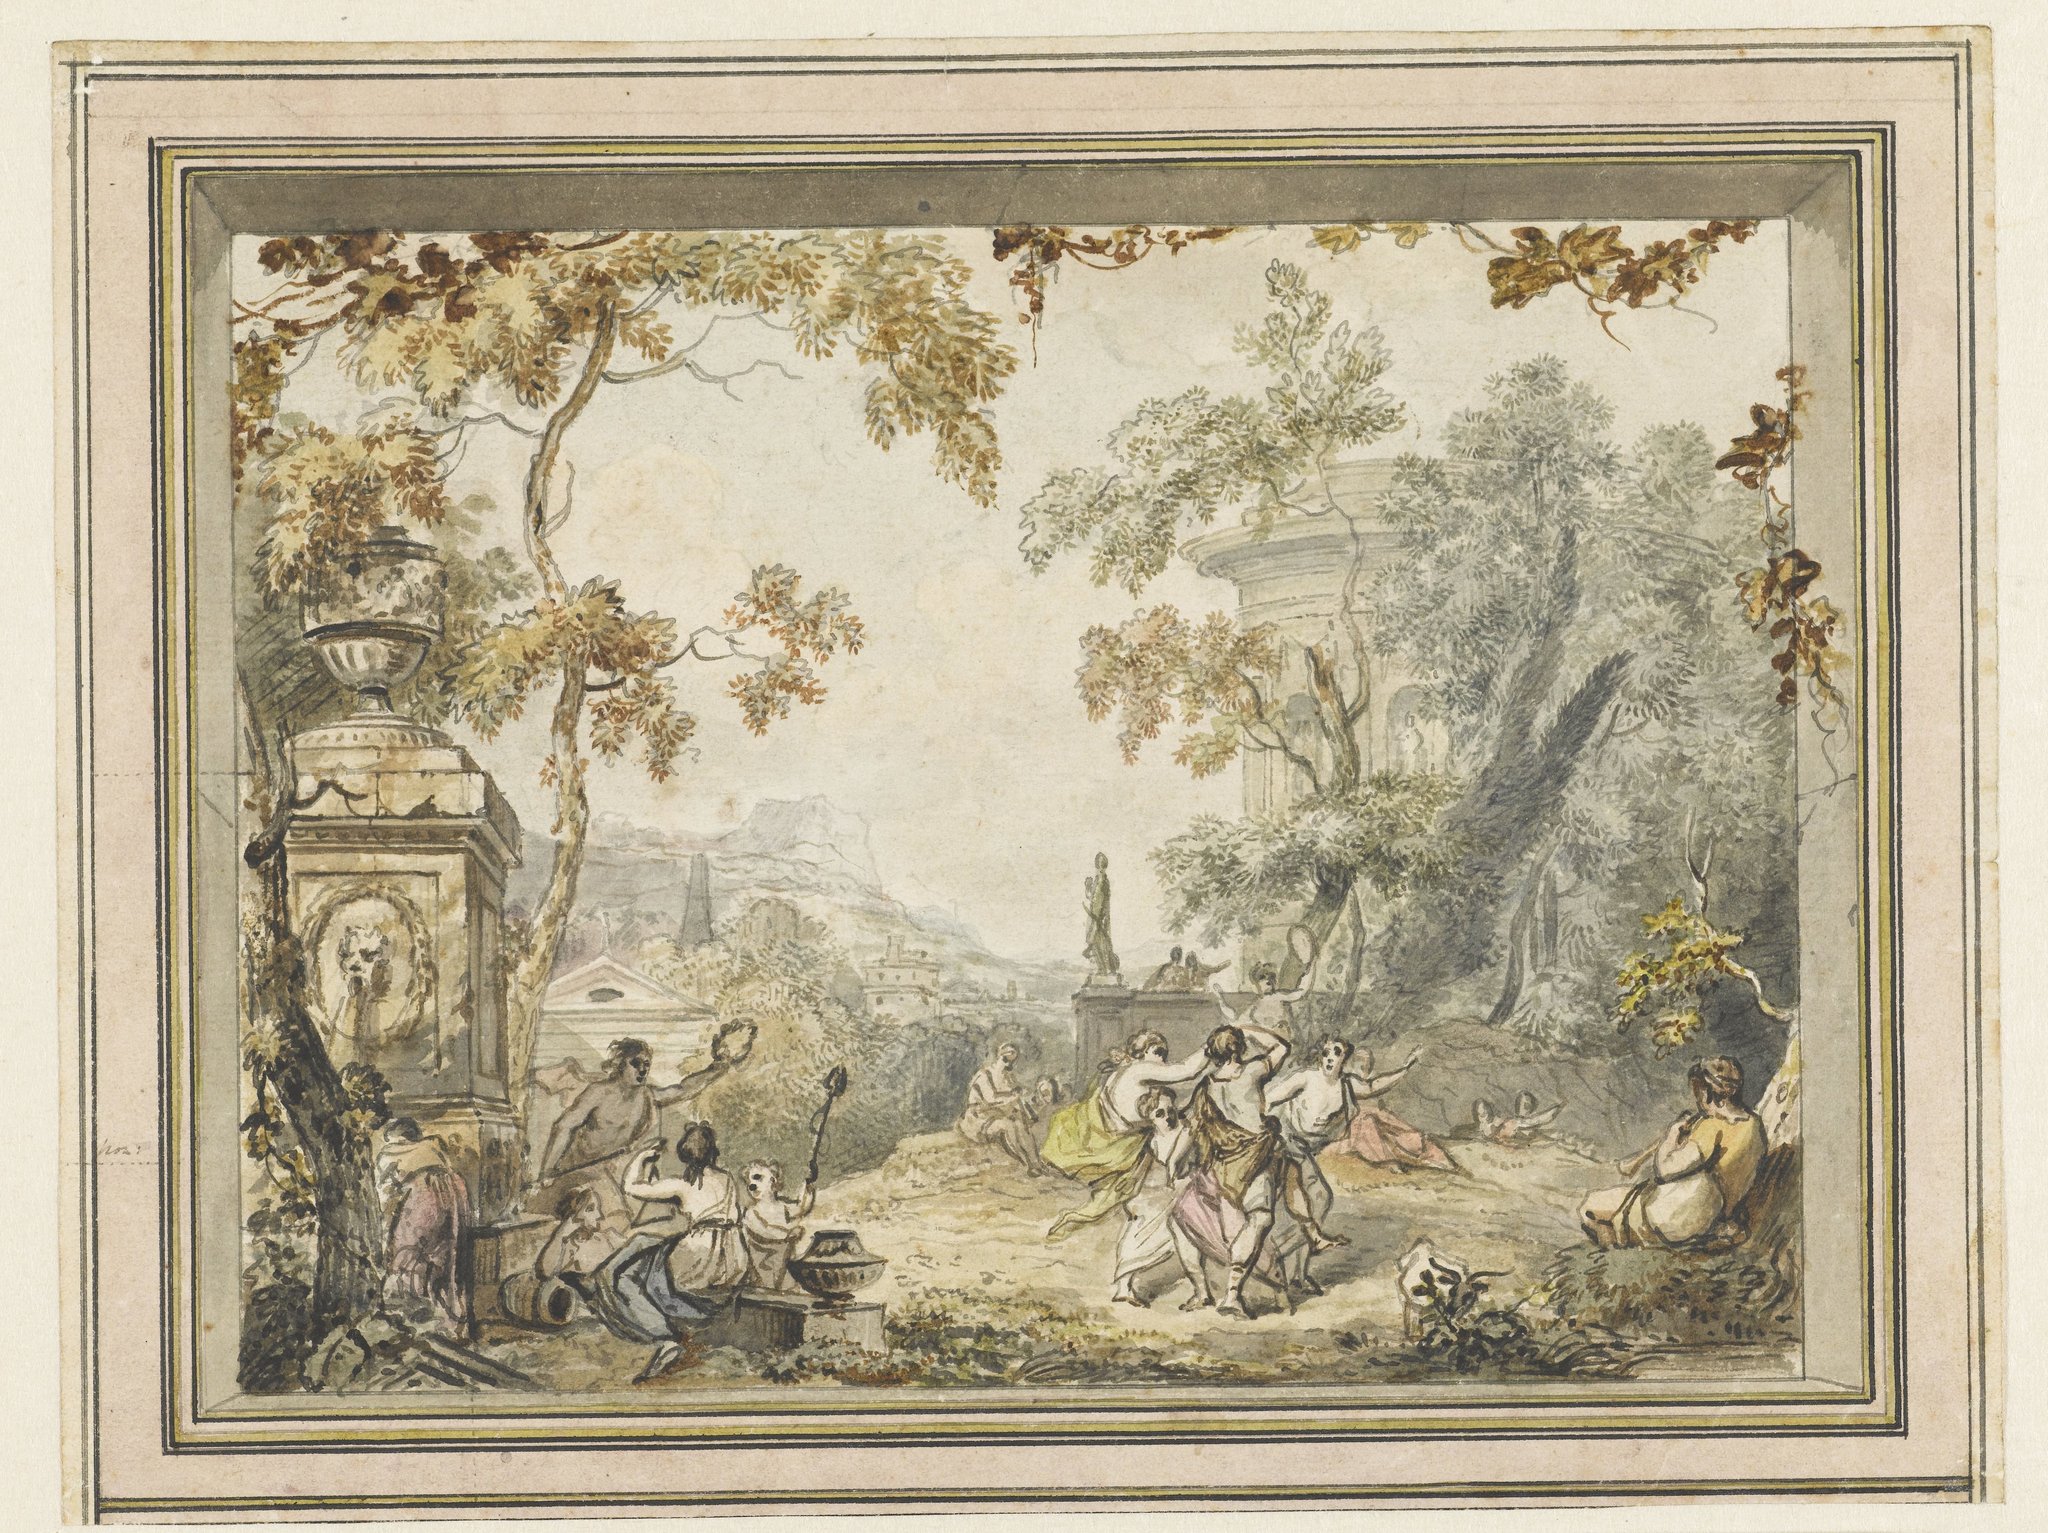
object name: design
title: Ontwerp voor een kamerbeschildering: idyllisch-arcadisch landschap met klassieke gebouwen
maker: jurriaan andriessen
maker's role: draughtsman, painter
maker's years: 1742-1819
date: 1752-1819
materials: ink, paper, pencil, watercolor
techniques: brush, pen